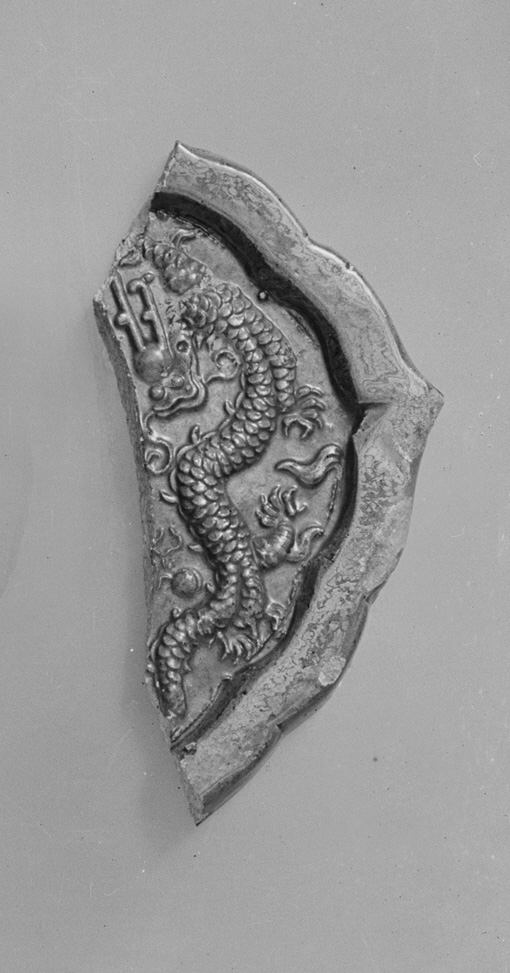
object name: roof tile fragment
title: Roof tile fragment with dragon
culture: chinese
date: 1501-1700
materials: earthenware, glaze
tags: dragons